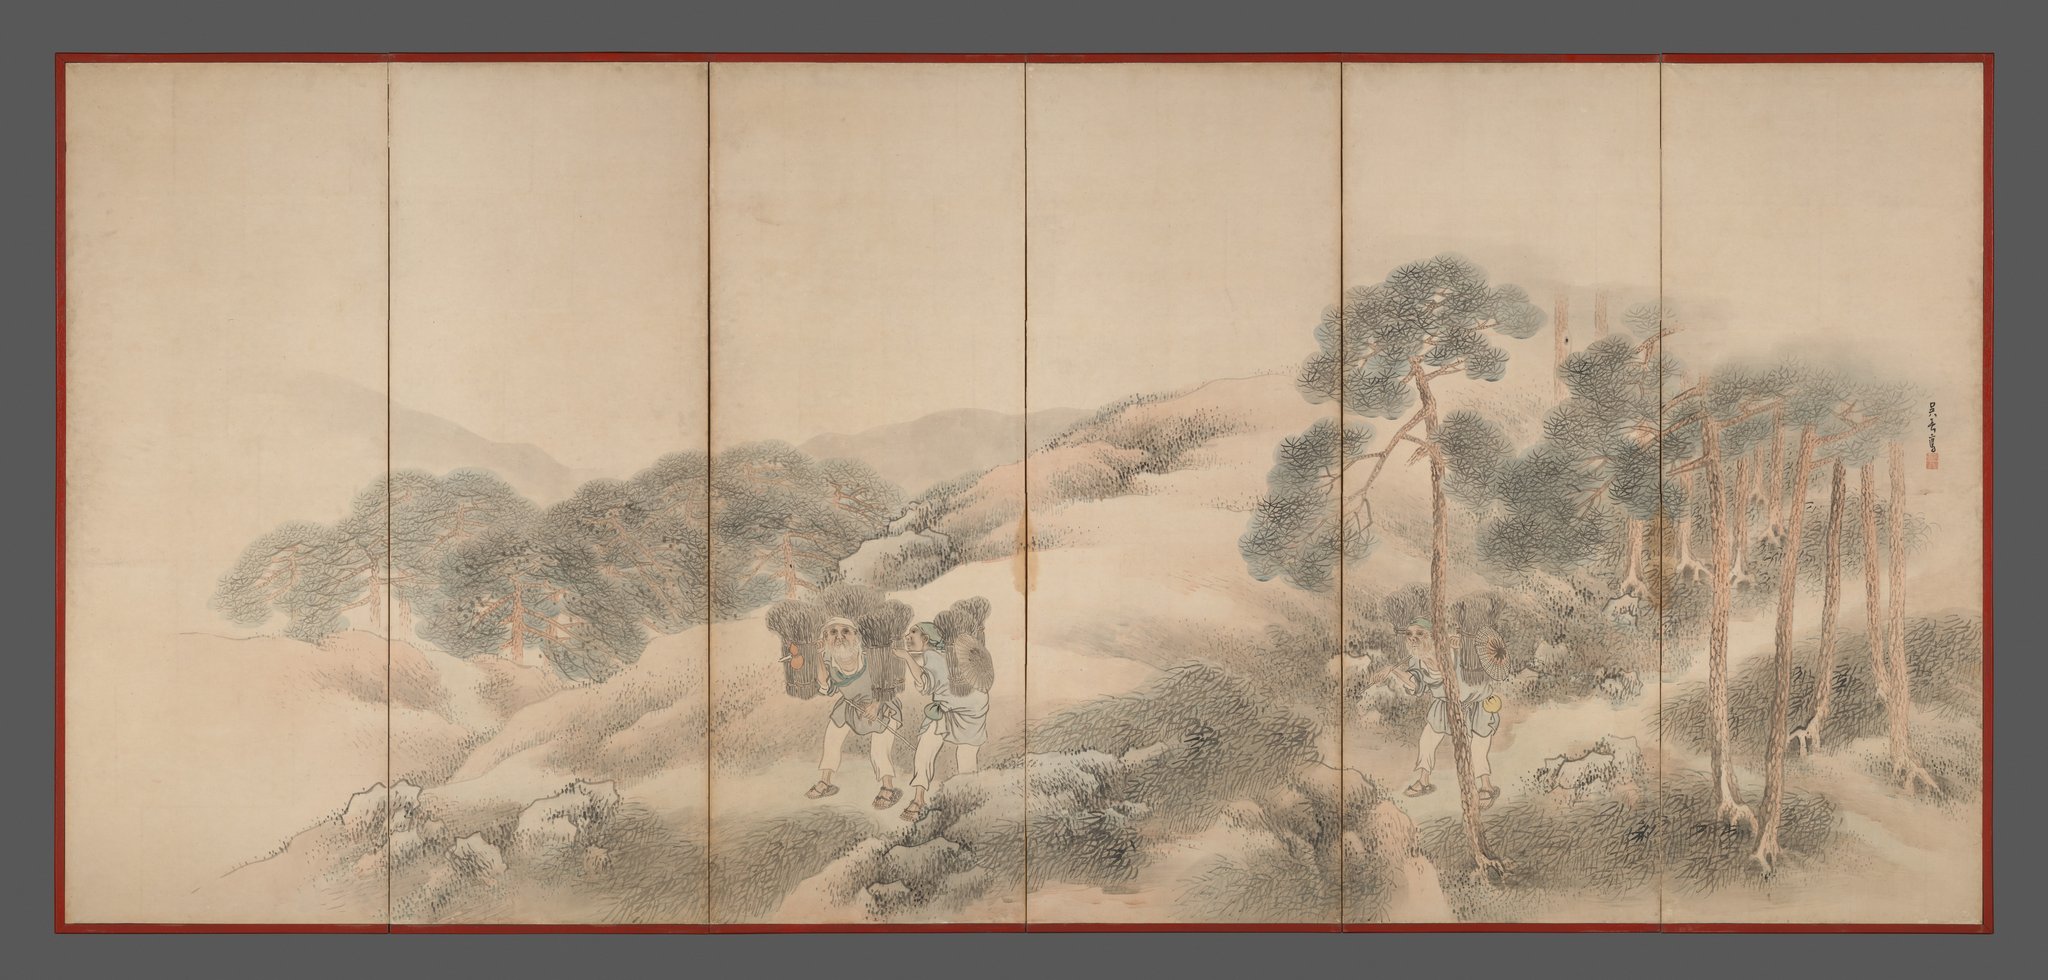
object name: screen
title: Woodcutters and Fishermen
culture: japanese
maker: matsumura goshun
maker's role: artist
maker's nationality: japanese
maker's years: 1752-1811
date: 1790-1795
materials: ink, panel, paper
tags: men,trees